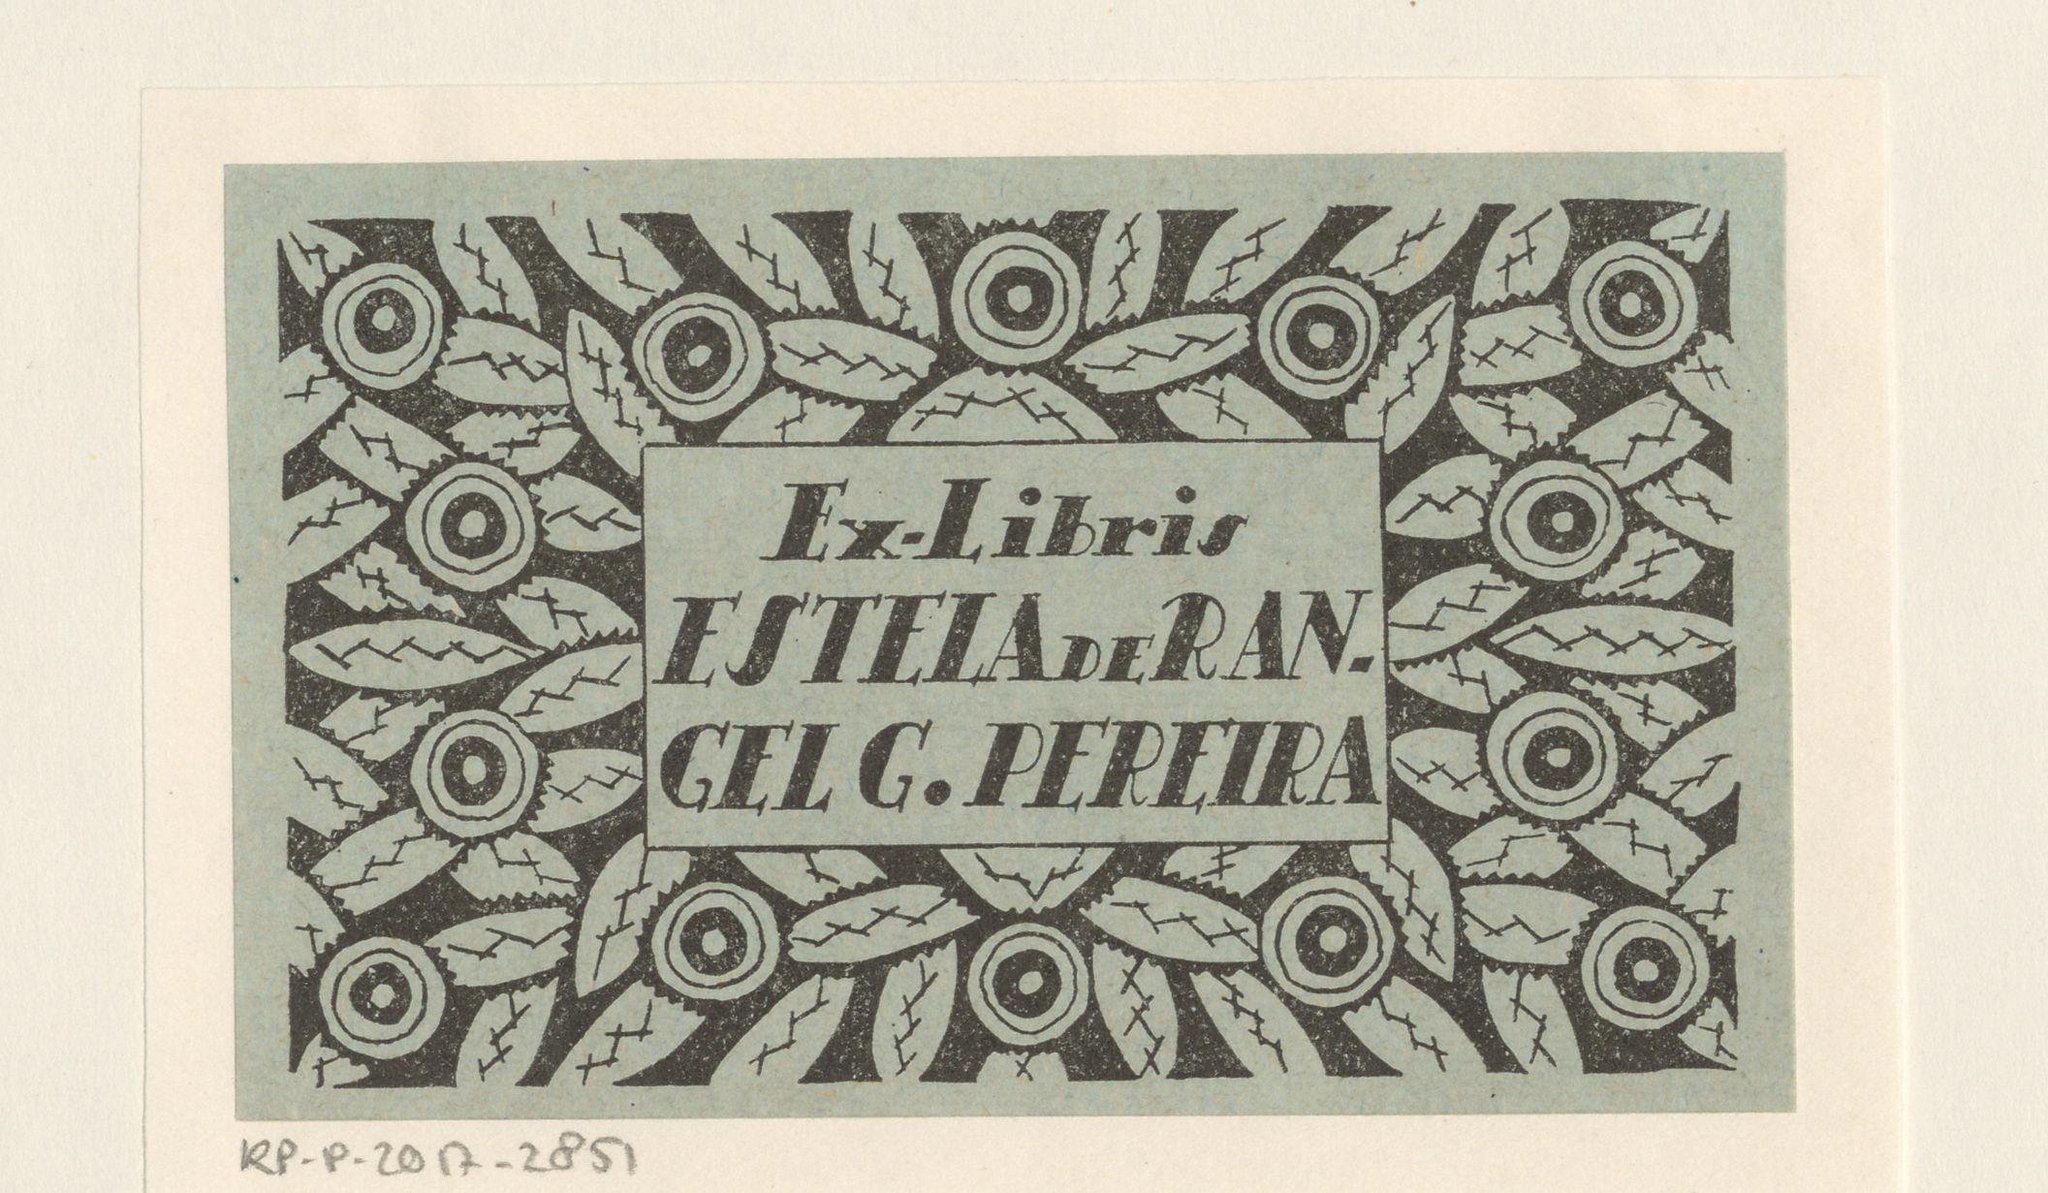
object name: bookplate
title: Ex libris van Estela de Rangel G. Pereira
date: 1900-1999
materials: paper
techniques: printing block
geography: portugal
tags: foliage ~ ornament - aa - stylized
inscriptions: workshop stamp: ‘8 / ipse fecit’